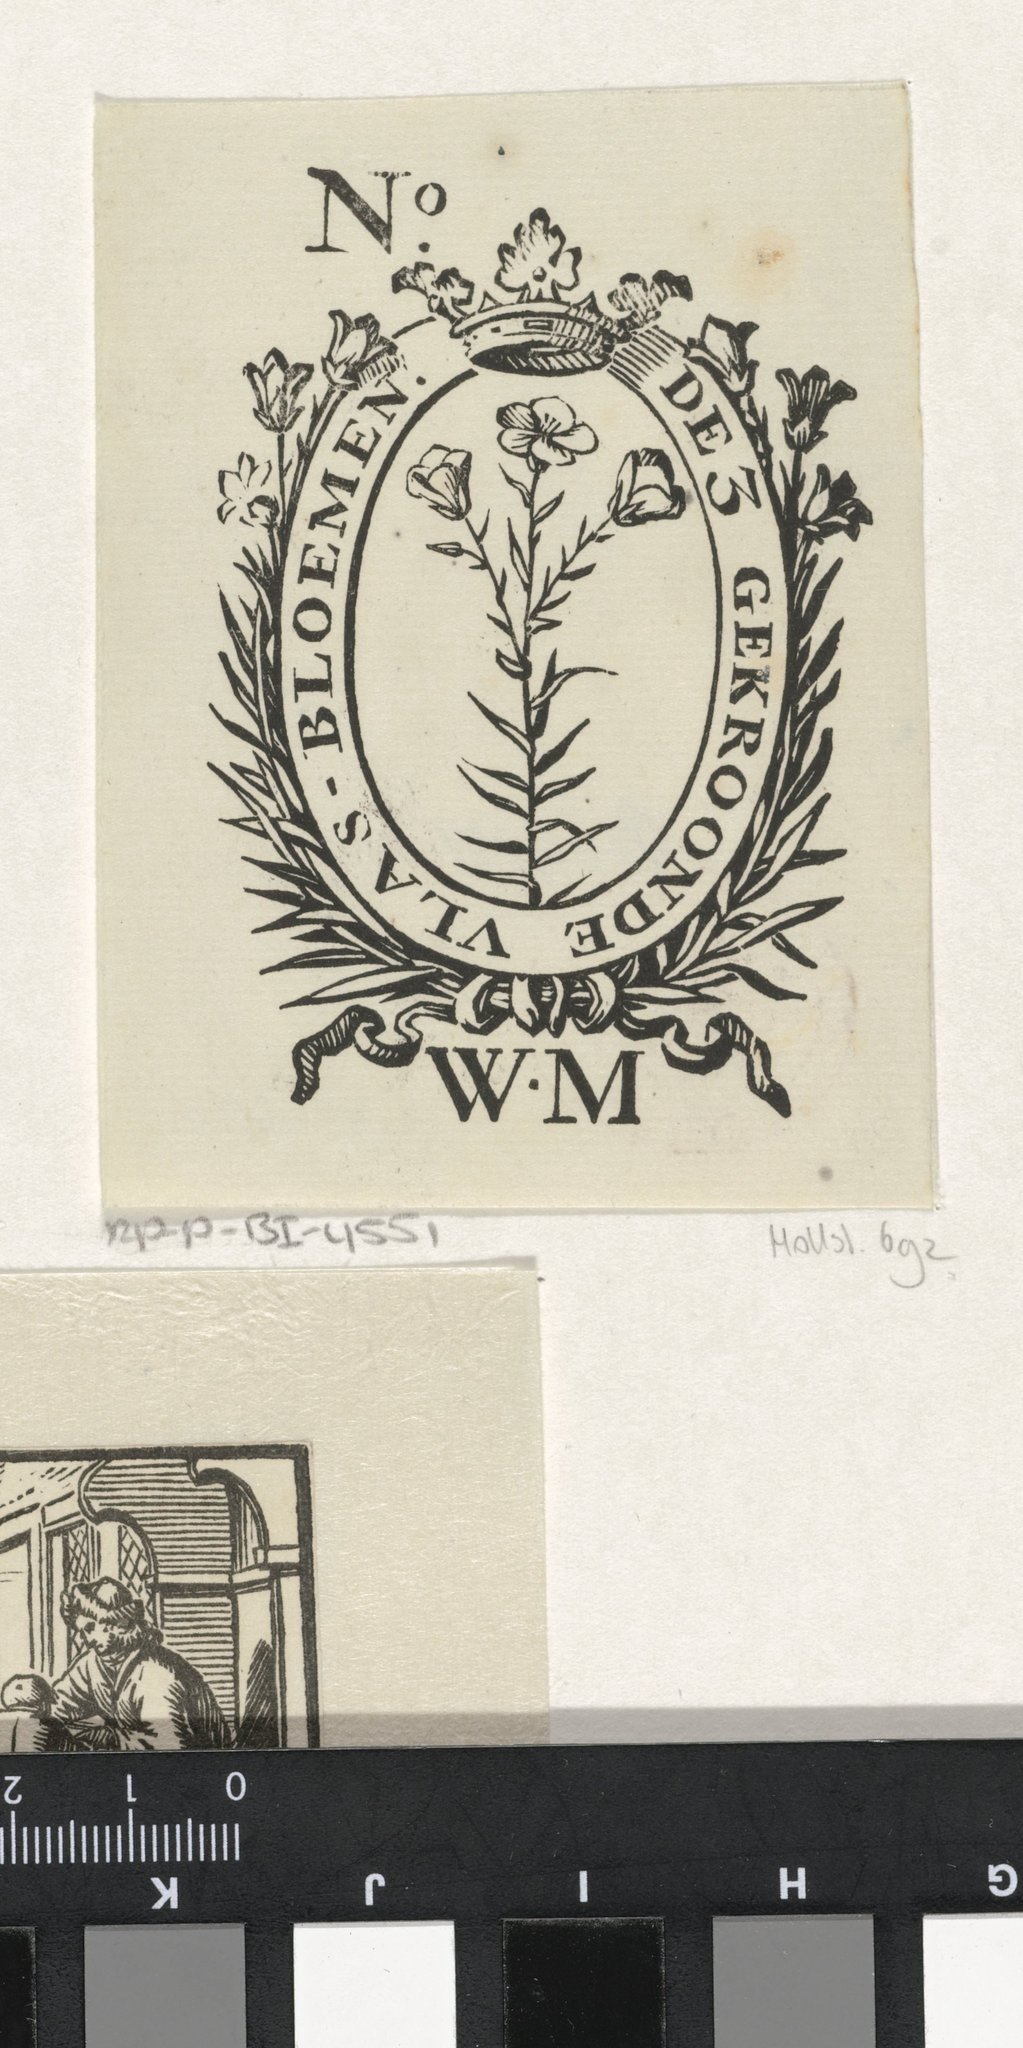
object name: handelsetiket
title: De 3 gekroonde vlas-bloemen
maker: isaac vincentsz. van der vinne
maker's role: draughtsman, print maker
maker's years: 1665-1740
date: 1681-1740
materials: paper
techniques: woodcut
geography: haarlem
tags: flowers, crown (symbol of sovereignty), vignette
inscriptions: collector's mark: Lugt 240